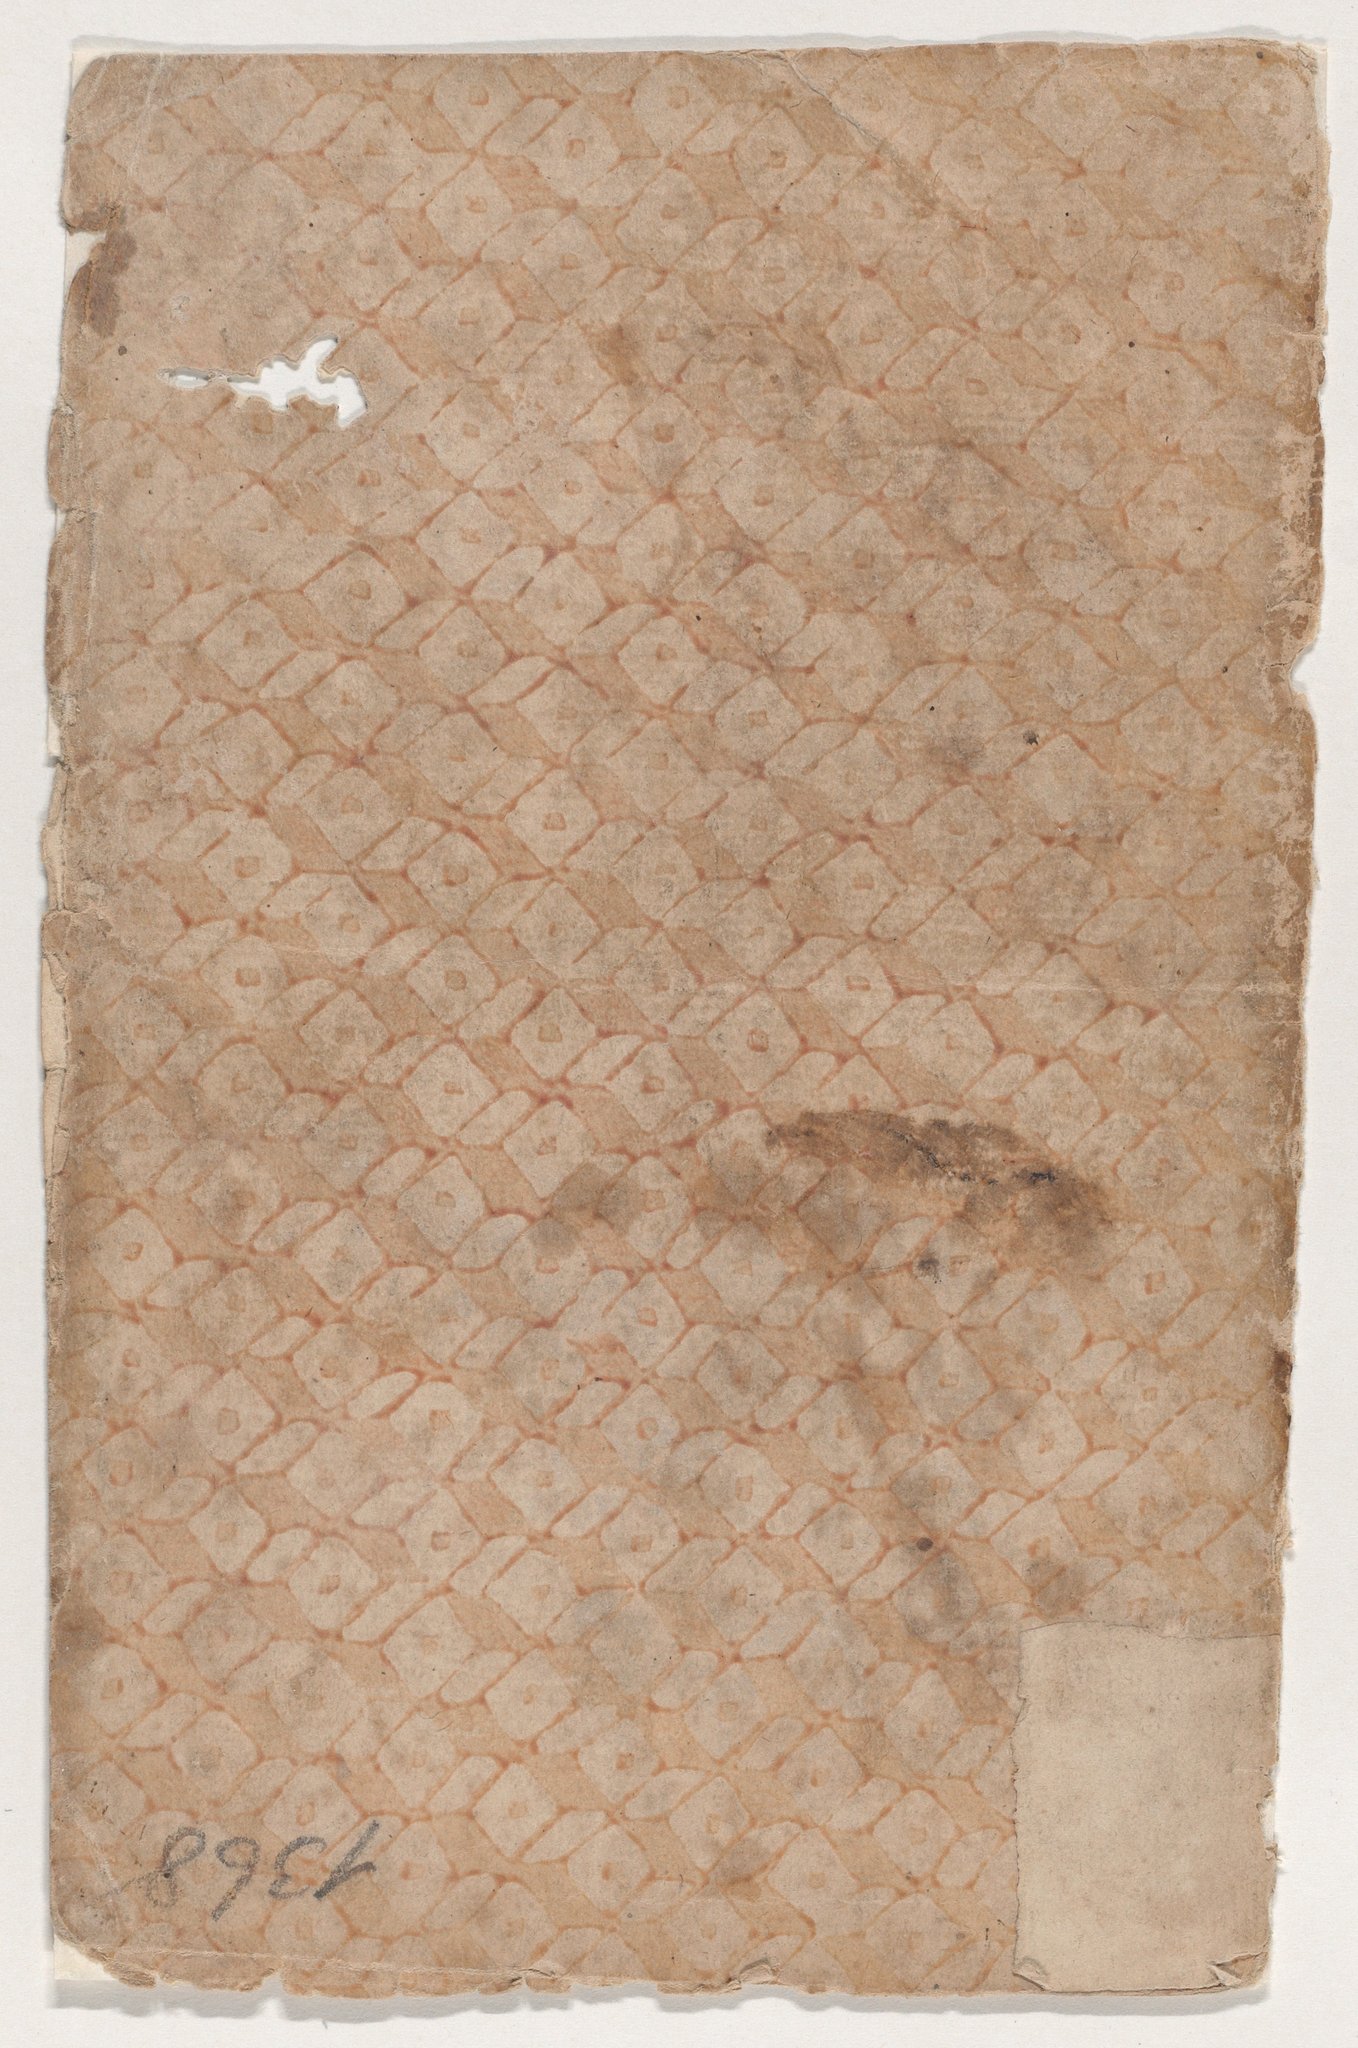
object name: print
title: Sheet with overall geometric pattern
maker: Anonymous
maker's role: artist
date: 1801-1900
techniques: relief print